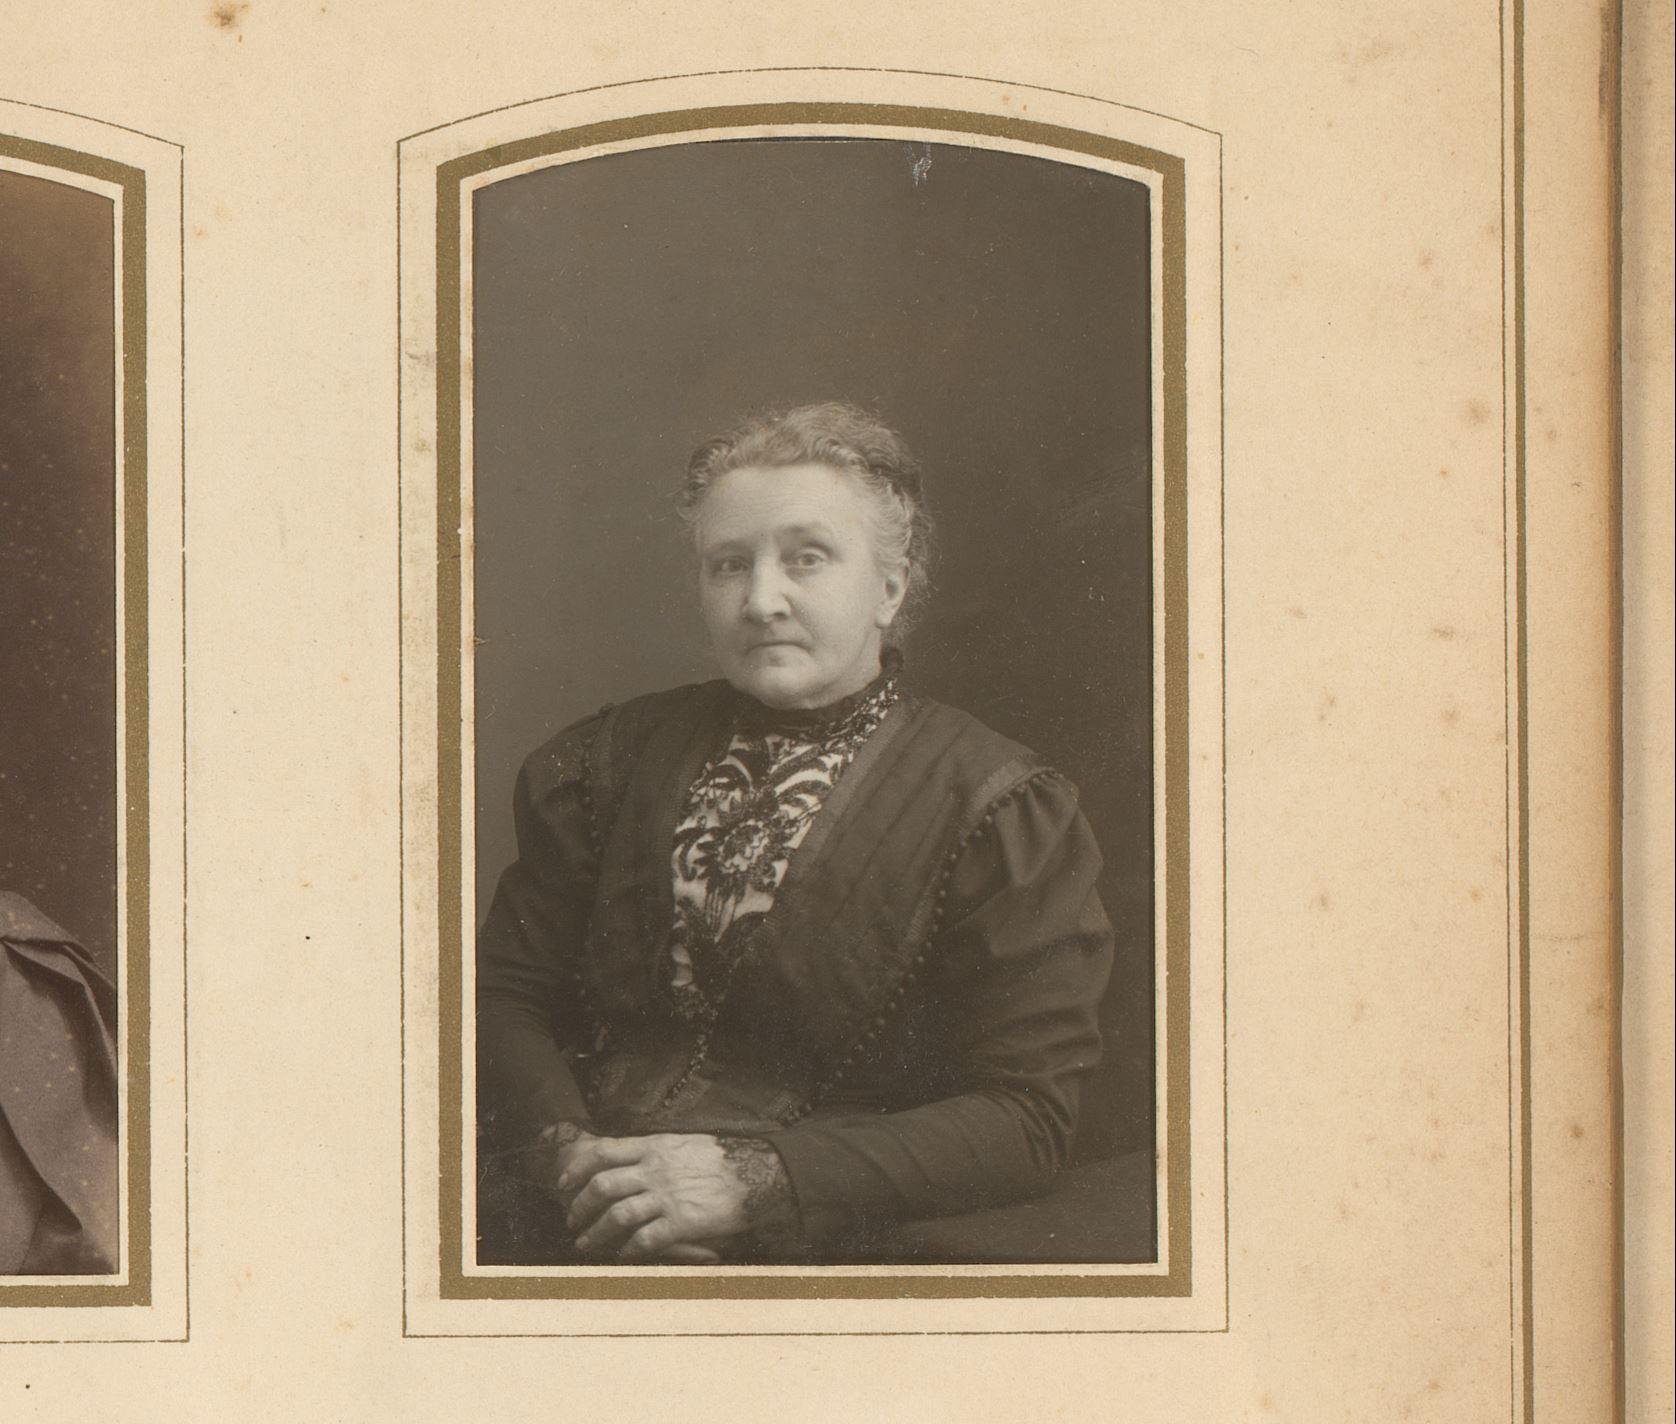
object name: carte de visite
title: Portret van een zittende vrouw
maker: hendrik venhuis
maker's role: fotograaf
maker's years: 1866-1938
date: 1904-1926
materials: cardboard, photographic support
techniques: matte daylight collodion silver print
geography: delfzijl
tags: sitting figure - aa - female human figure, historical persons - bb - woman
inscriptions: inscription: ‘H. Venhuis Gzn/ DELFZYL’